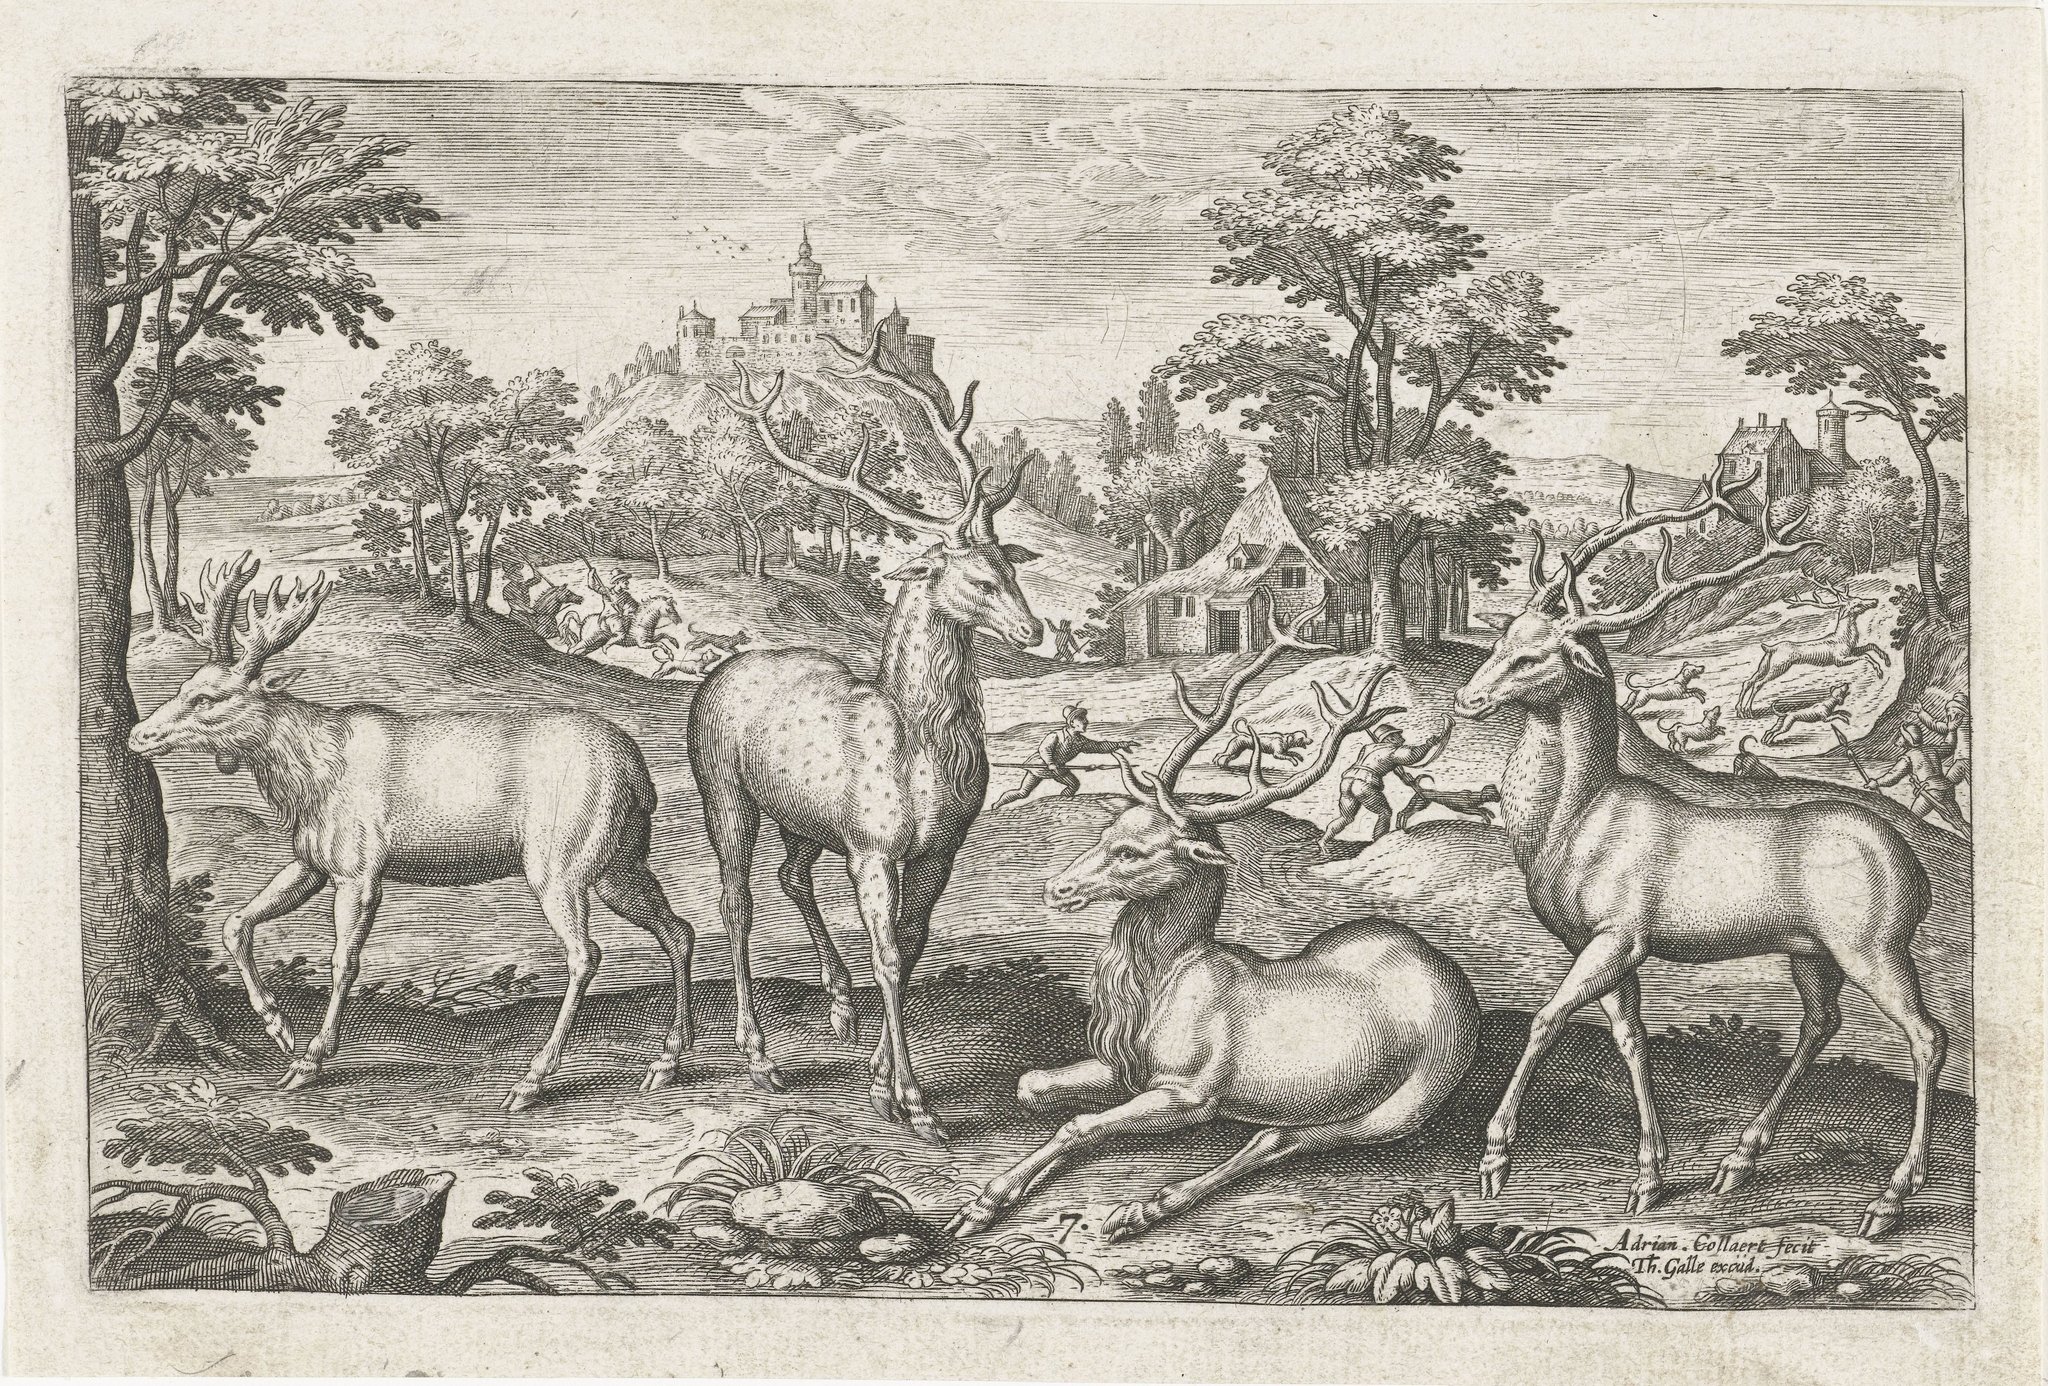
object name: print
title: Animalivm Qvaddrvpedvm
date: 1595-1633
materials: paper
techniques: engraving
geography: antwerp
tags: hoofed animals: deer, stag-hunting, hoofed animals: moose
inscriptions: collector's mark: Lugt 2228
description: Twee herten, een damhert en een eland op de voorgrond. Op de achtergrond een hertenjacht. De prent maakt deel uit van een serie met dieren als onderwerp.